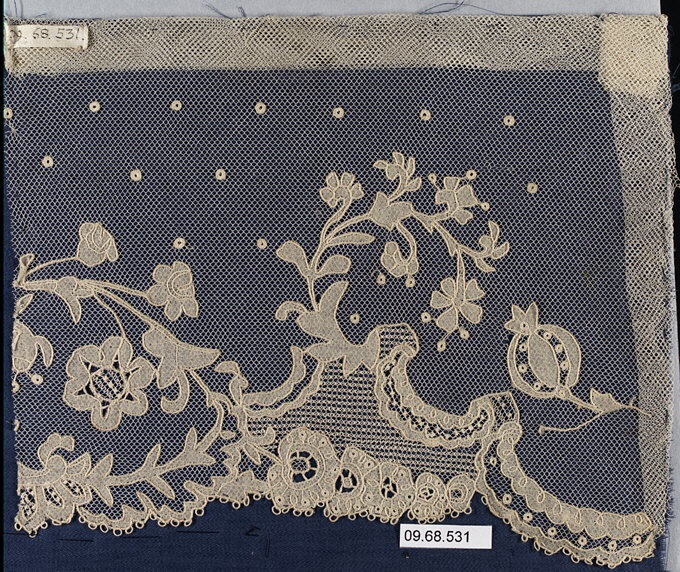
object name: fragment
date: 1802